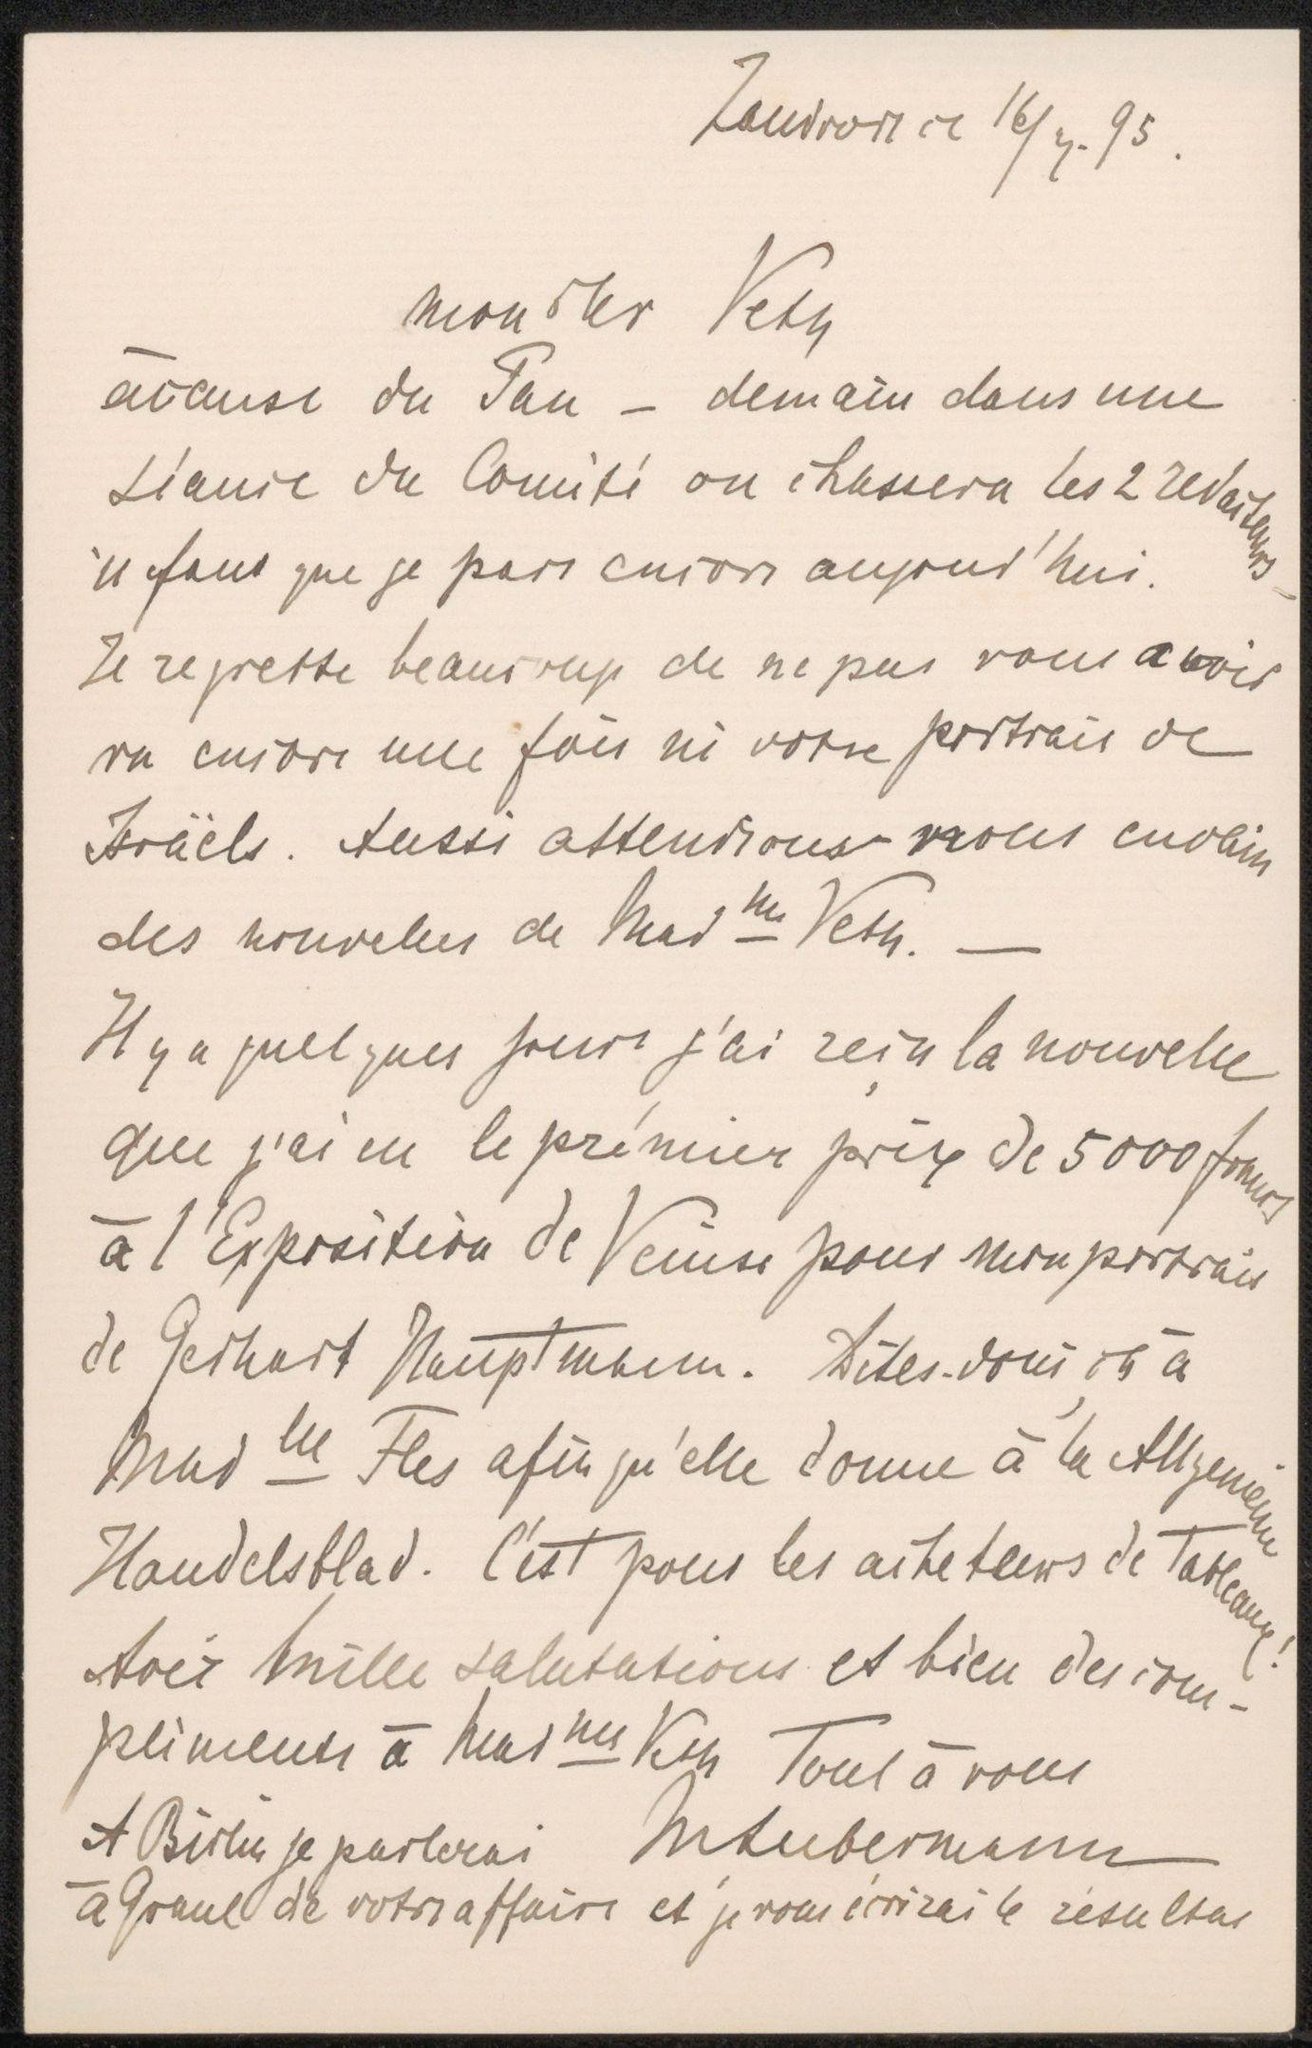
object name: letter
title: Brief aan Jan Veth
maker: max liebermann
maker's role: draughtsman, print maker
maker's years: 1847-1935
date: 1895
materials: ink, paper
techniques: pen, writing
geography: zandvoort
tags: dordrecht, painter, jan veth, utrecht, etha fles, distribution of awards ~ art contest, exhibition ~ art, historical persons (portraits and scenes from the life), venice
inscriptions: collector's mark: ‘RPK’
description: Opgenomen in: Ernst Braun, Max Liebermann: Briefe 1869-1895, Baden-Baden: Deutscher Wissenschafts-Verlag, 2011, Band 1, p. 448-450.